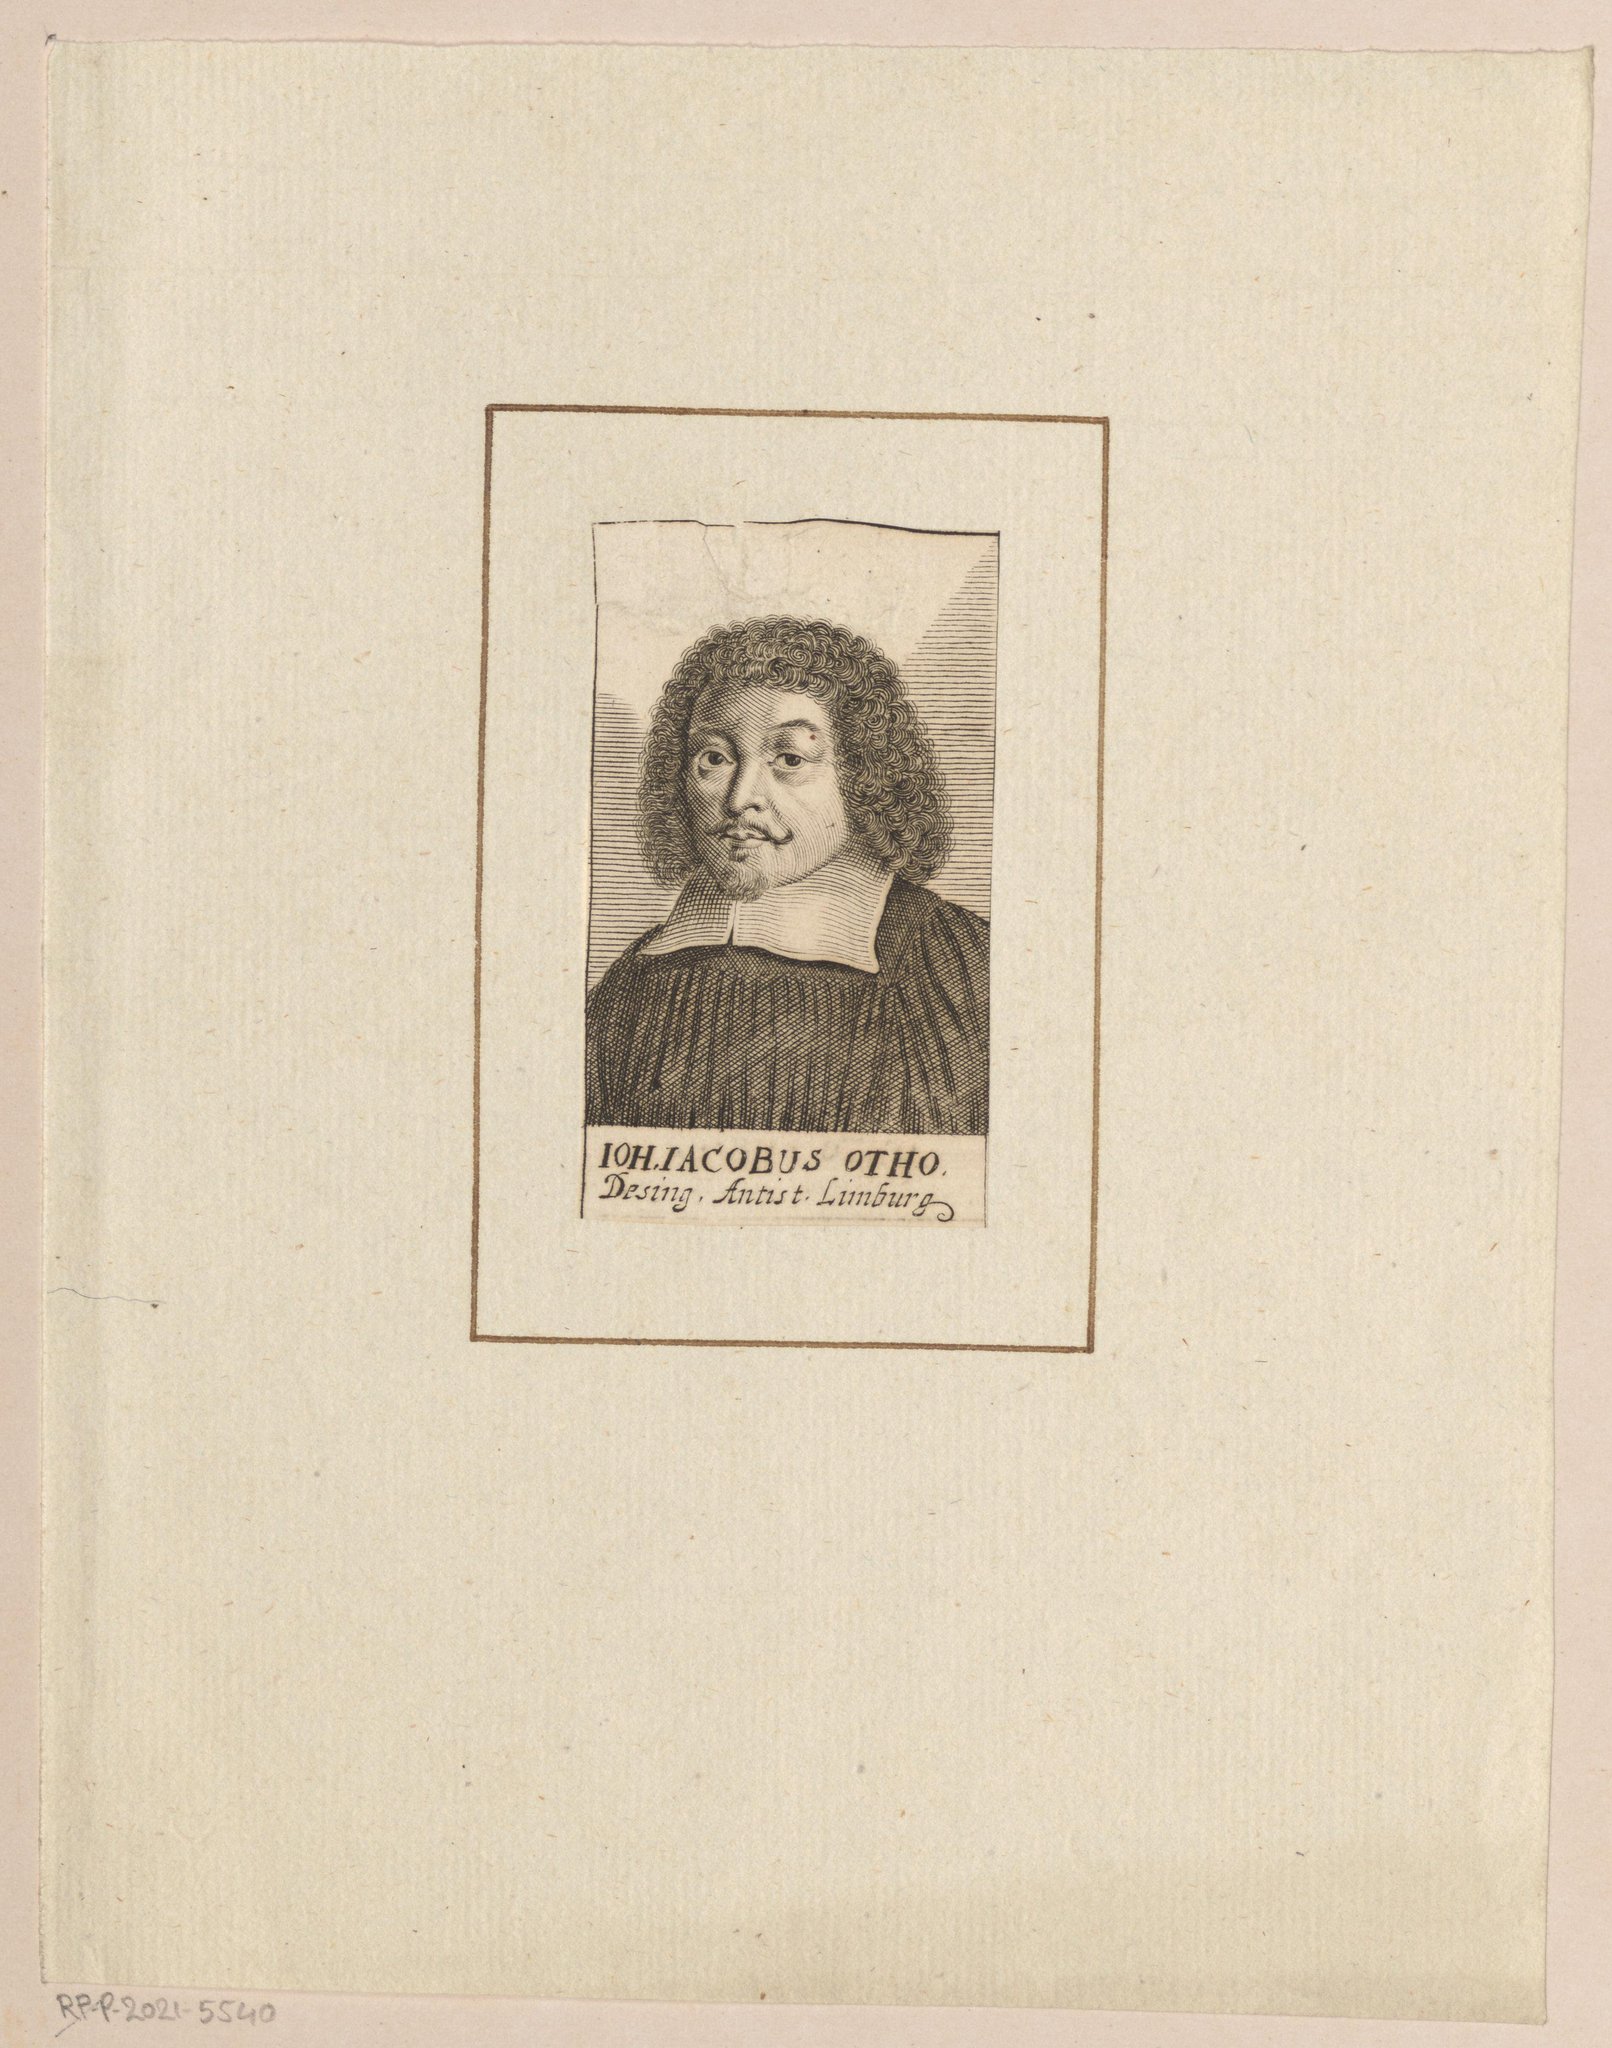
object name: print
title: Portret van Johann Jacob Otho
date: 1688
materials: paper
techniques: engraving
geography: nuremberg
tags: historical persons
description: Prent mogelijk uit: Freher, Paul. Theatrum virorum eruditione clarorum. Neurenberg: Johann Hoffmann, 1688.